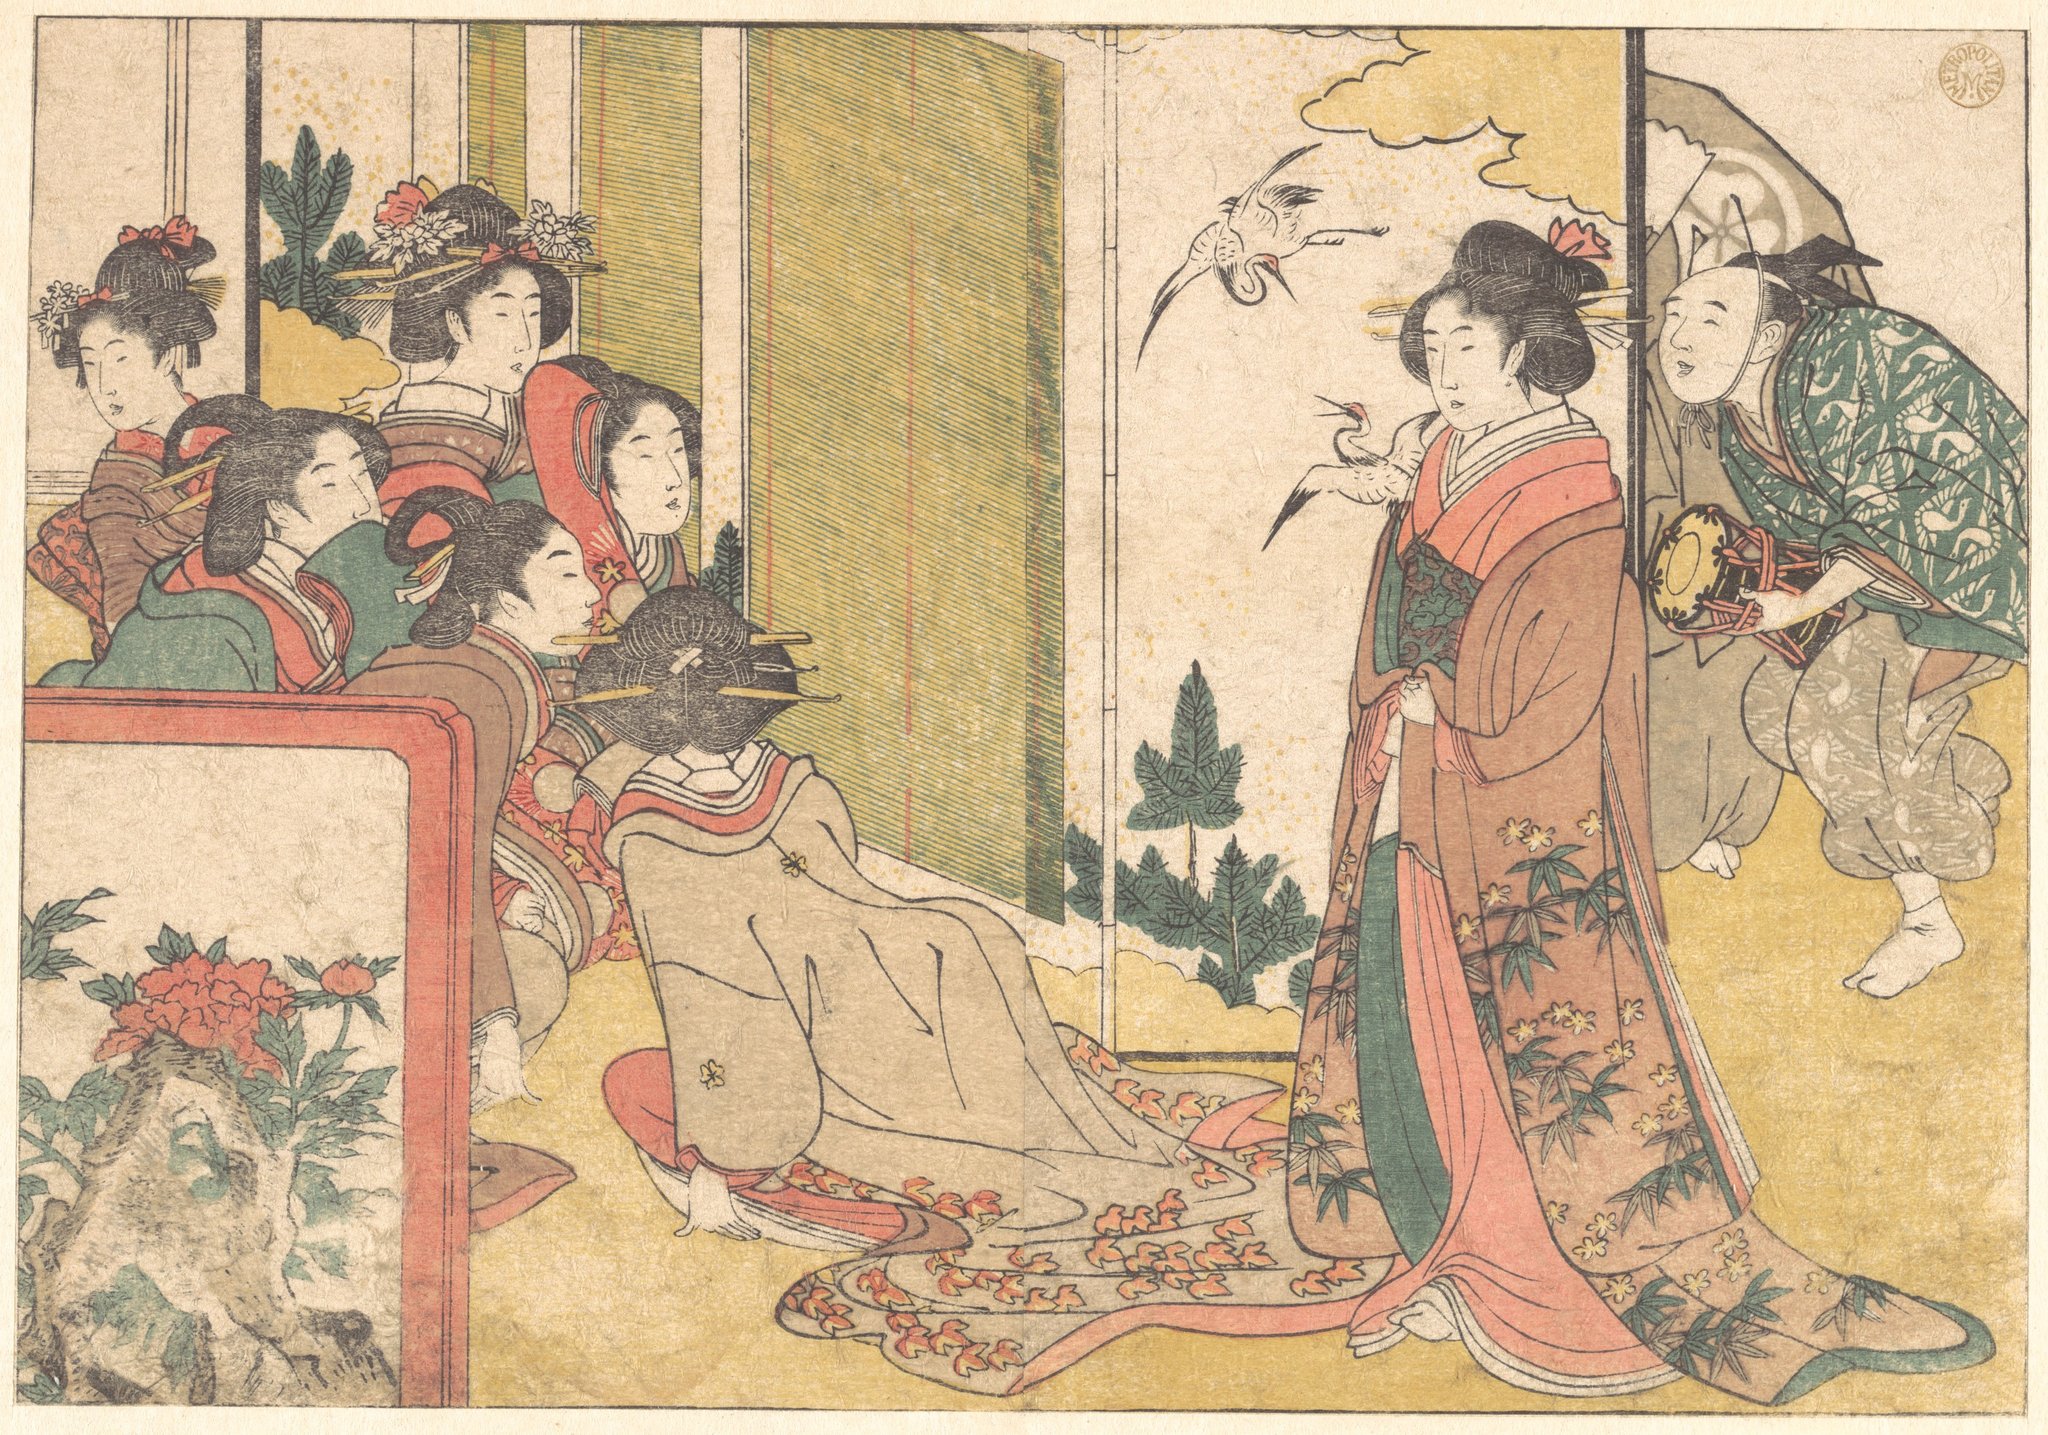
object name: woodblock print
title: Girls Entertained by Performers, from the illustrated book Flowers of the Four Seasons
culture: japanese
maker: kitagawa utamaro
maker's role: artist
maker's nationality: japanese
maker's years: 1754-1806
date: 1801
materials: ink, paper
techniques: woodblock print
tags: performance,women,actors